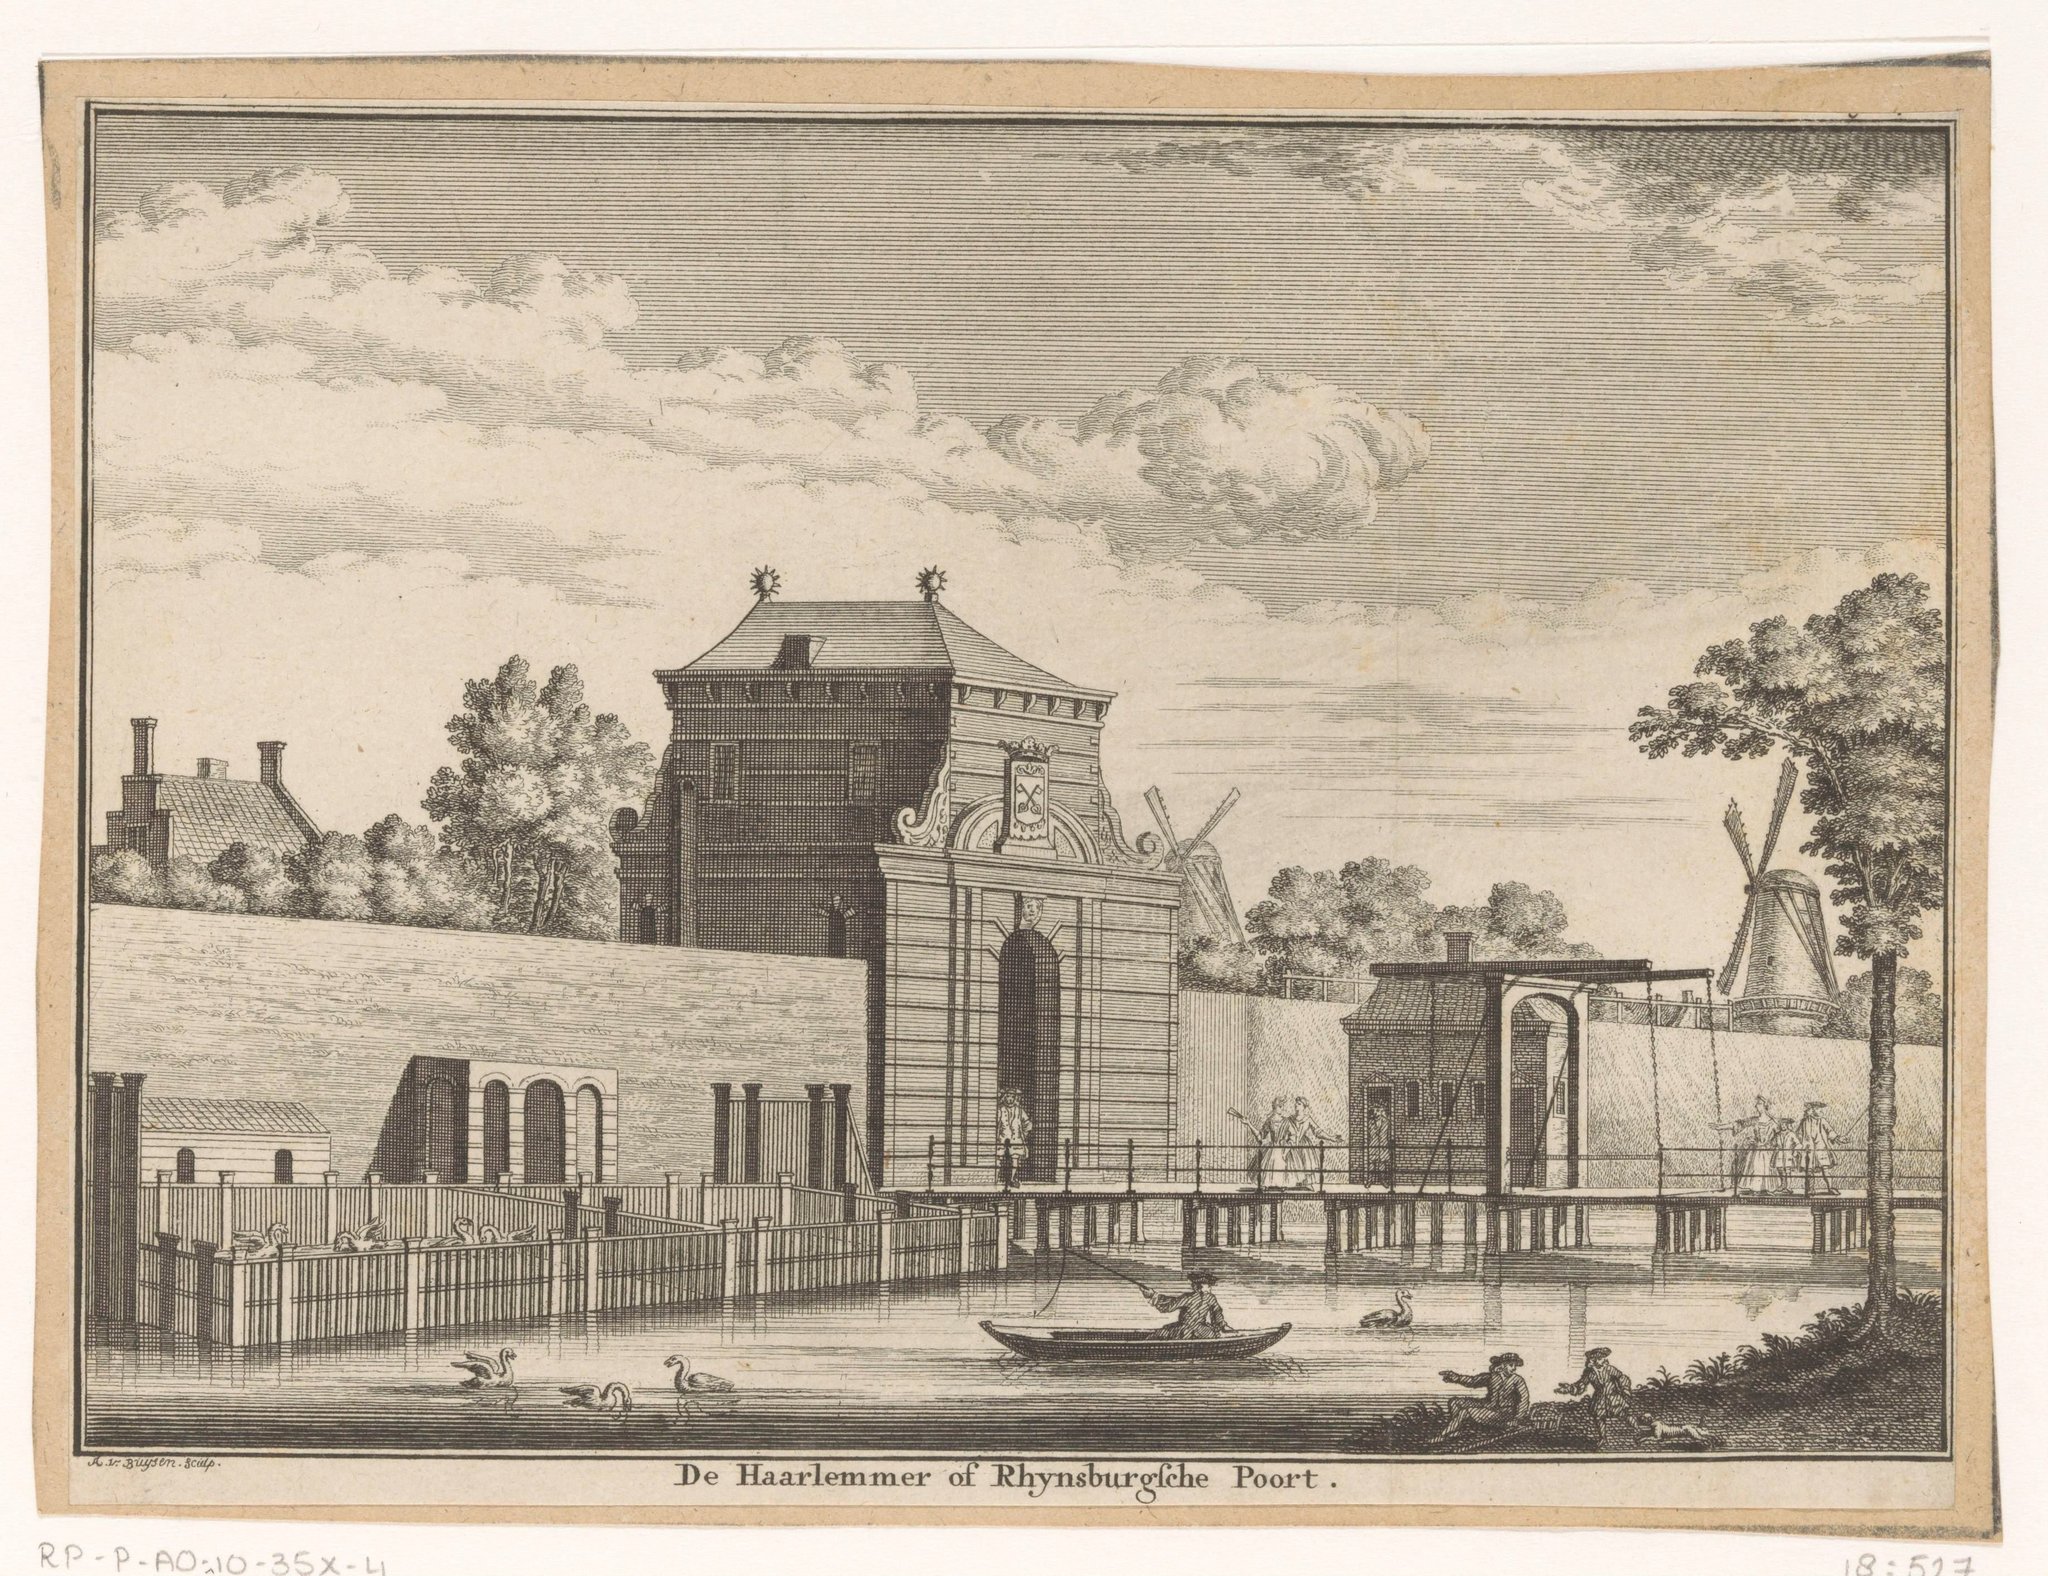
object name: book illustration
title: Gezicht op de Rijnsburgerpoort te Leiden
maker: andries van buysen (sr.)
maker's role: print maker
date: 1734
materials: paper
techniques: engraving, etching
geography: amsterdam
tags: bridge, city-gate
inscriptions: collector's mark: Lugt 2228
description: Prent ook gebruikt in: De vermakelyke Leidsche buiten-cingels, aangenaame dorpen en landstreken, rondom die stad gelegen (…) versiert met alle de stadts-poorten. Leiden: Quirinum Visscher, Amsterdam: Arent van Huyssteen, 1734.